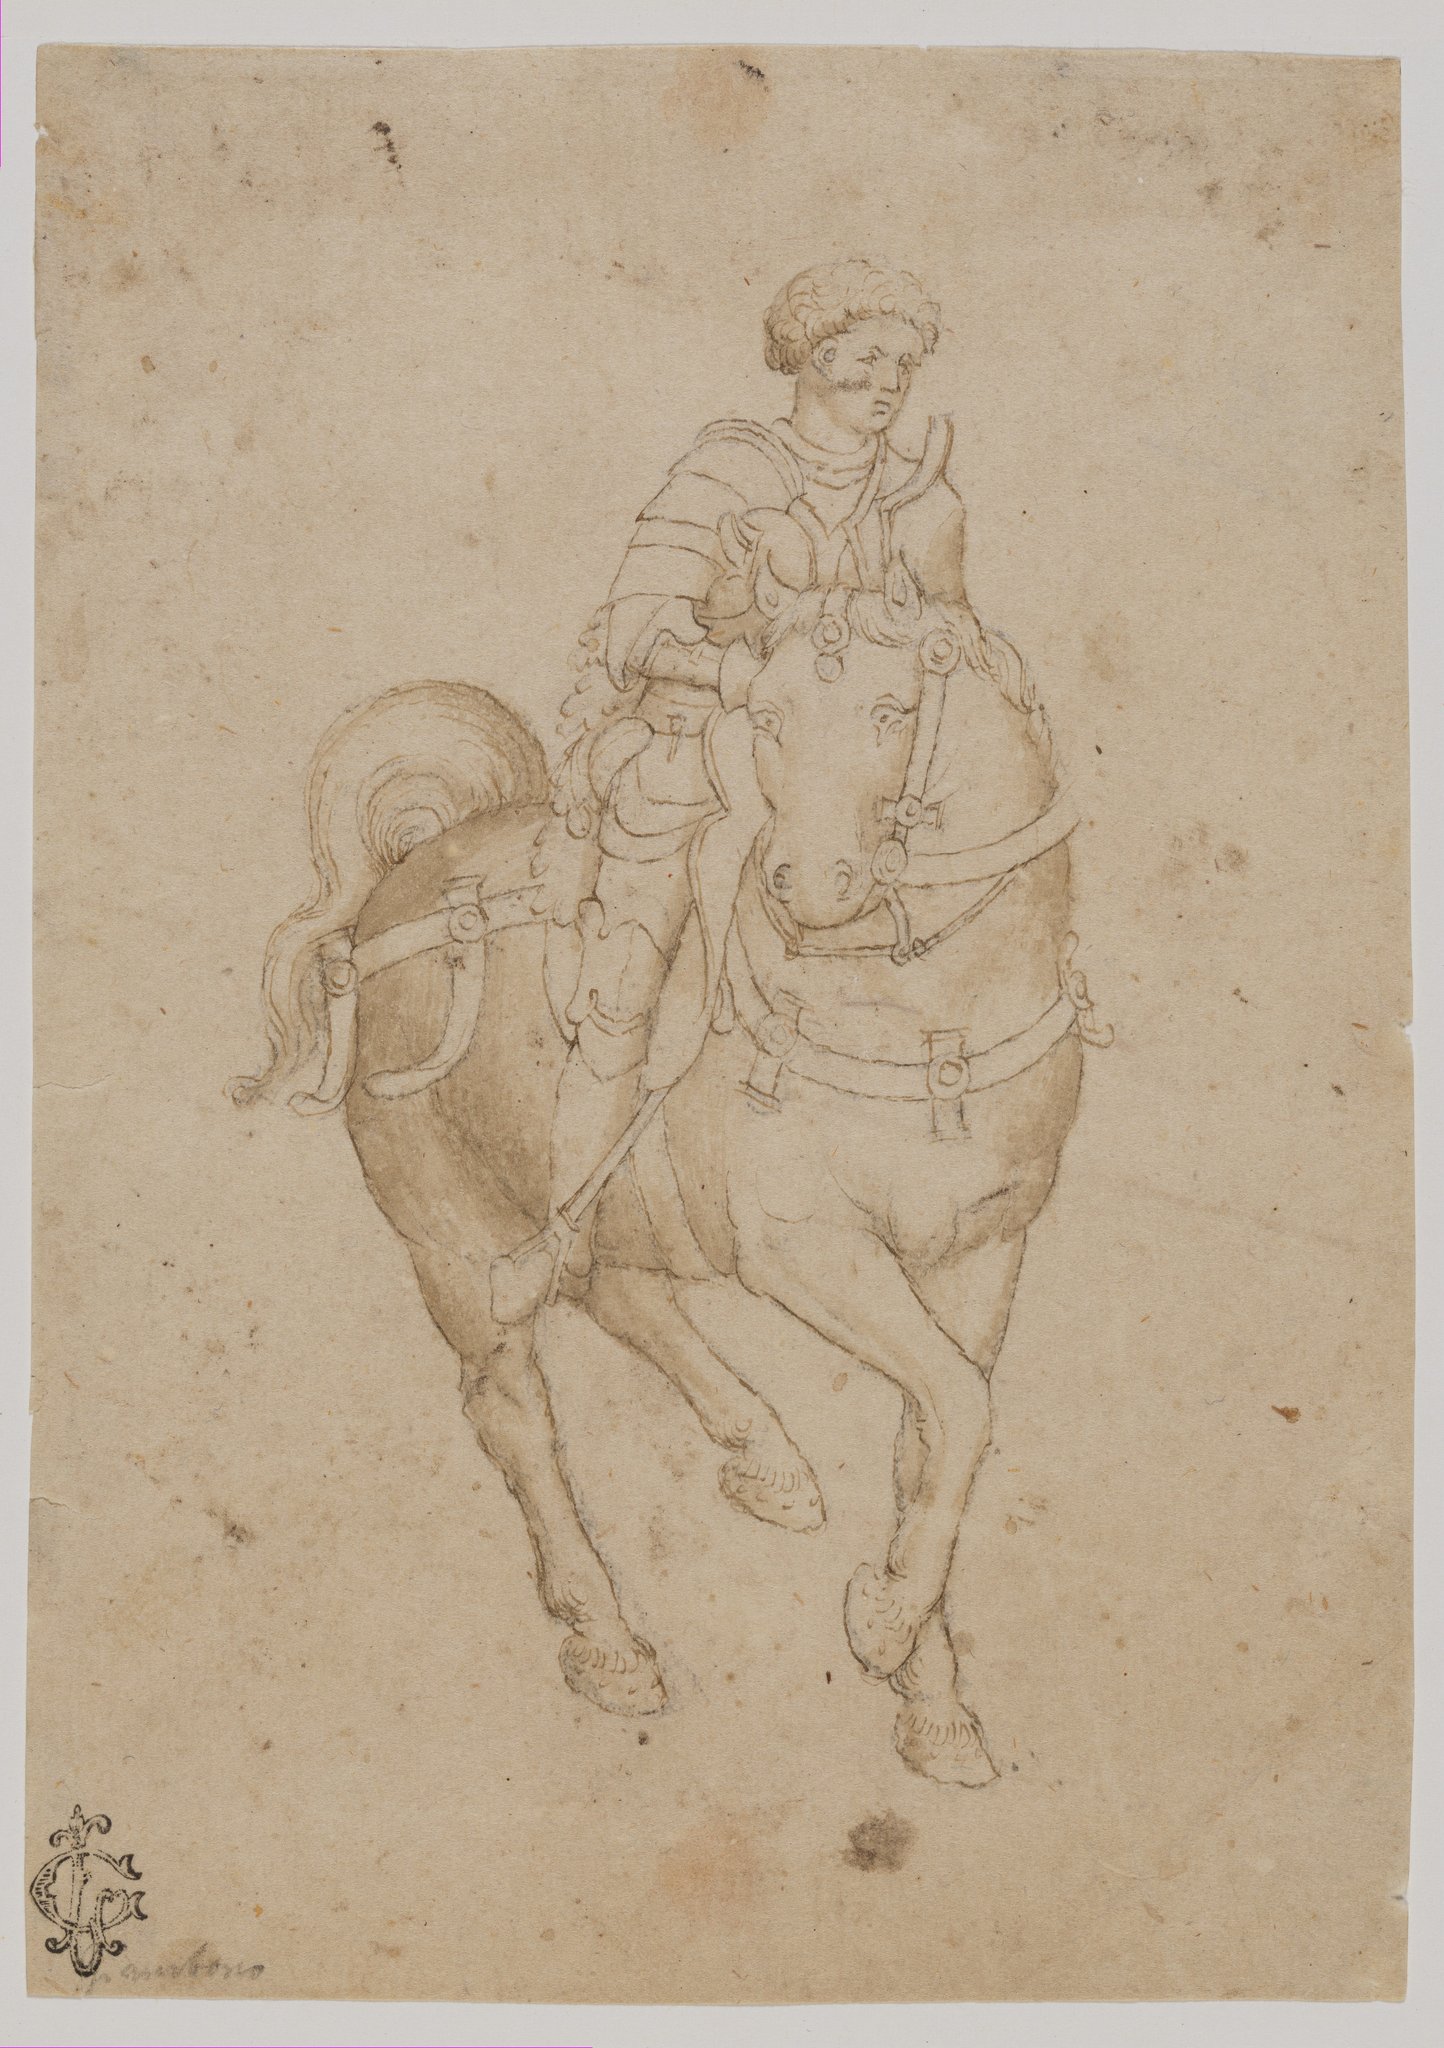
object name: drawing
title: A Warrior on Horseback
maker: the veneto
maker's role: artist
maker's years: 1425-1449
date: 1426-1450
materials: chalk, ink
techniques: pen, wash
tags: men,horses,warriors